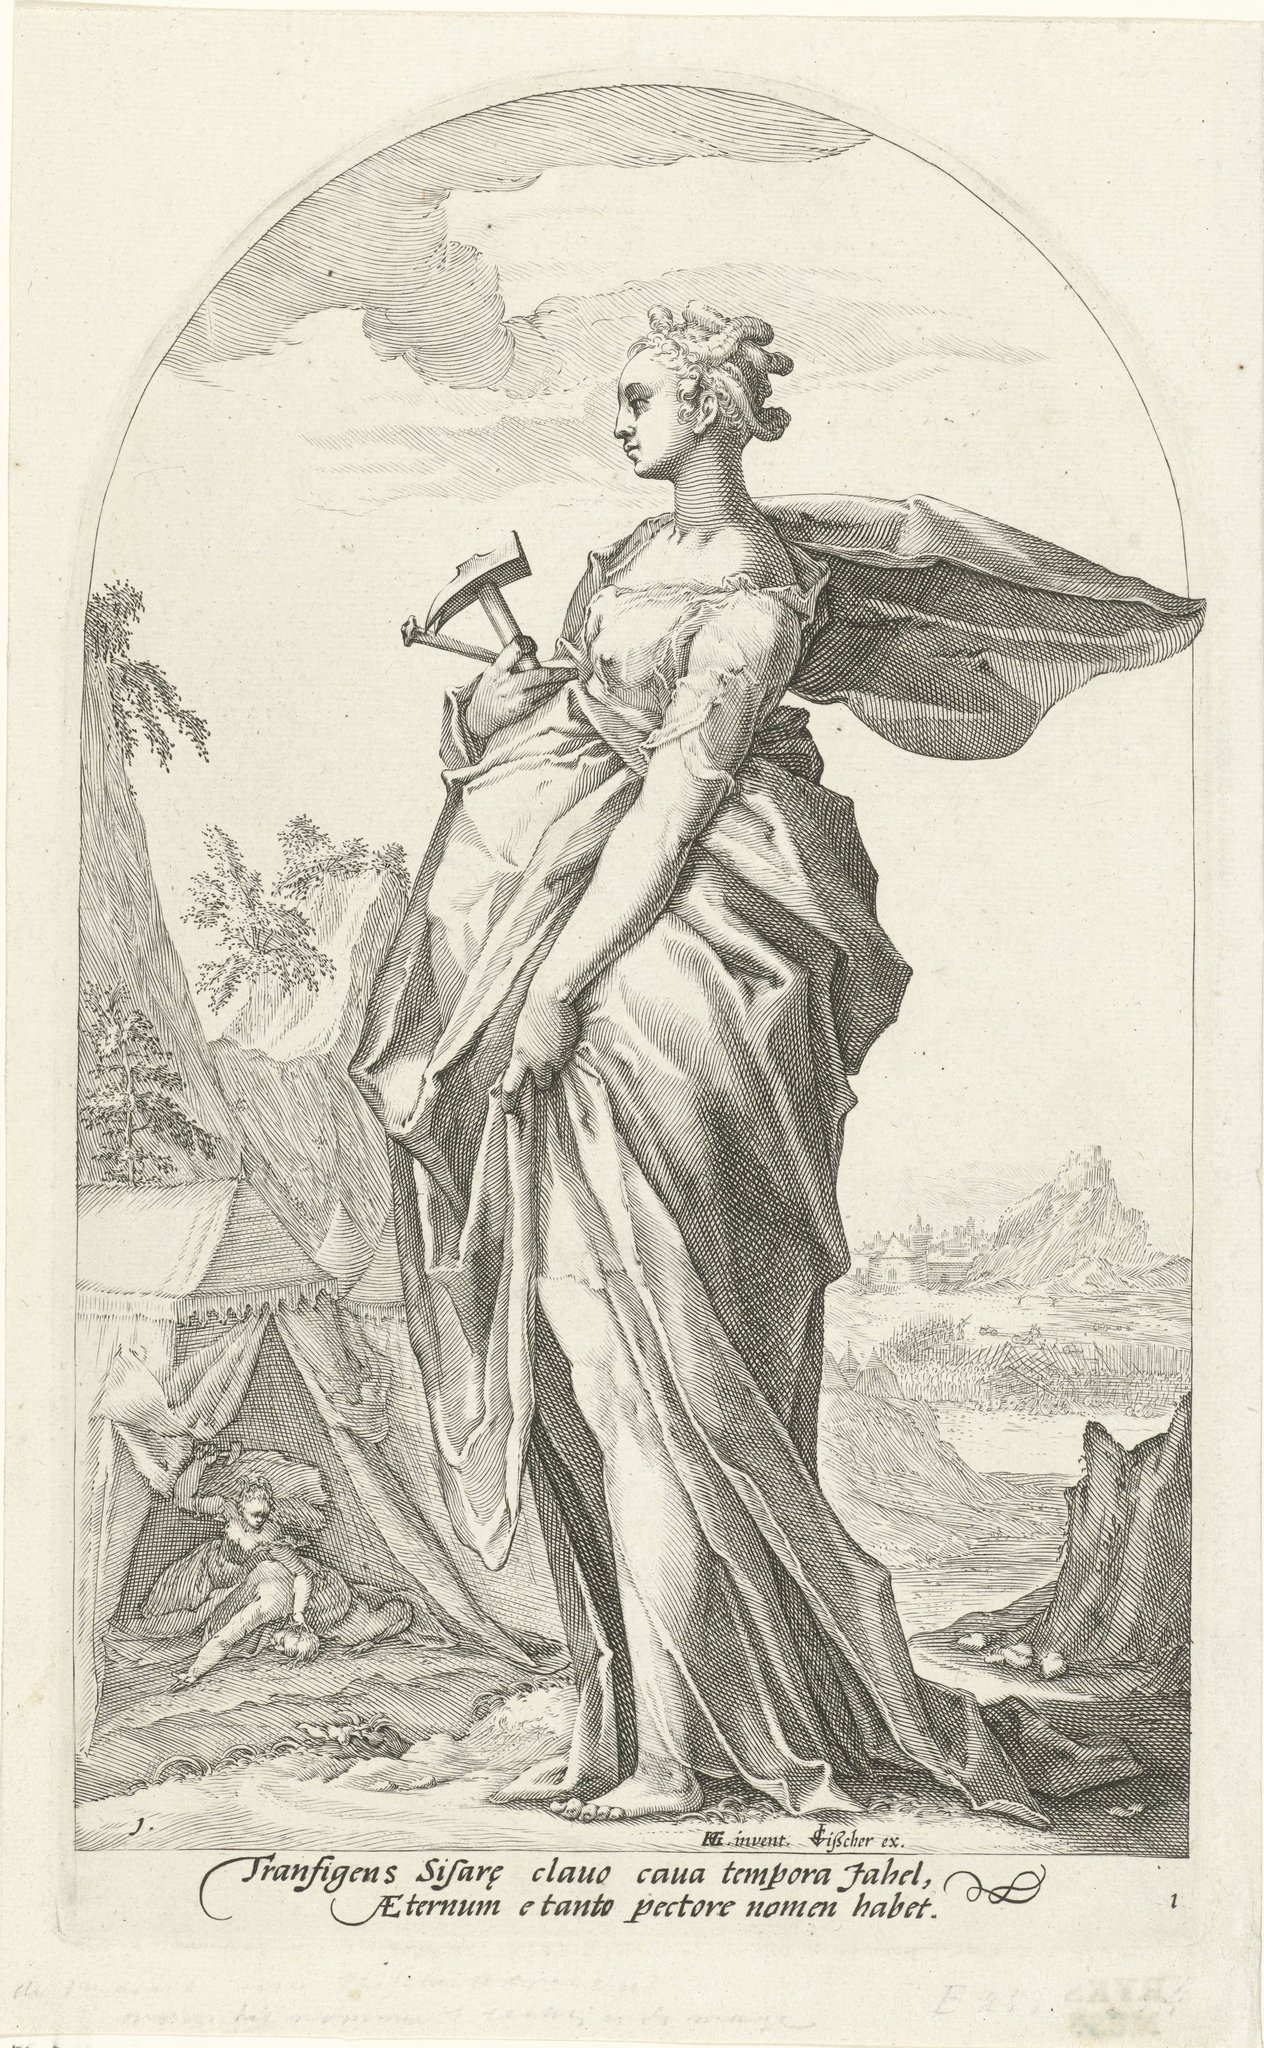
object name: print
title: Helden en heldinnen van het Oude Testament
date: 1585-1589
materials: paper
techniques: engraving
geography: amsterdam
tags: story of jael and sisera, jael (one of the nine worthiest women), female persons from the old testament (with name) (not in biblical context)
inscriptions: collector's mark: Lugt 2165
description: Jaël met in haar hand hamer en tentpin. Op de achtergrond de scène waarin Jaël hiermee de generaal Sisera vermoordt, door hem de tentpin in zijn slaap door het hoofd te slaan in zijn legertent.